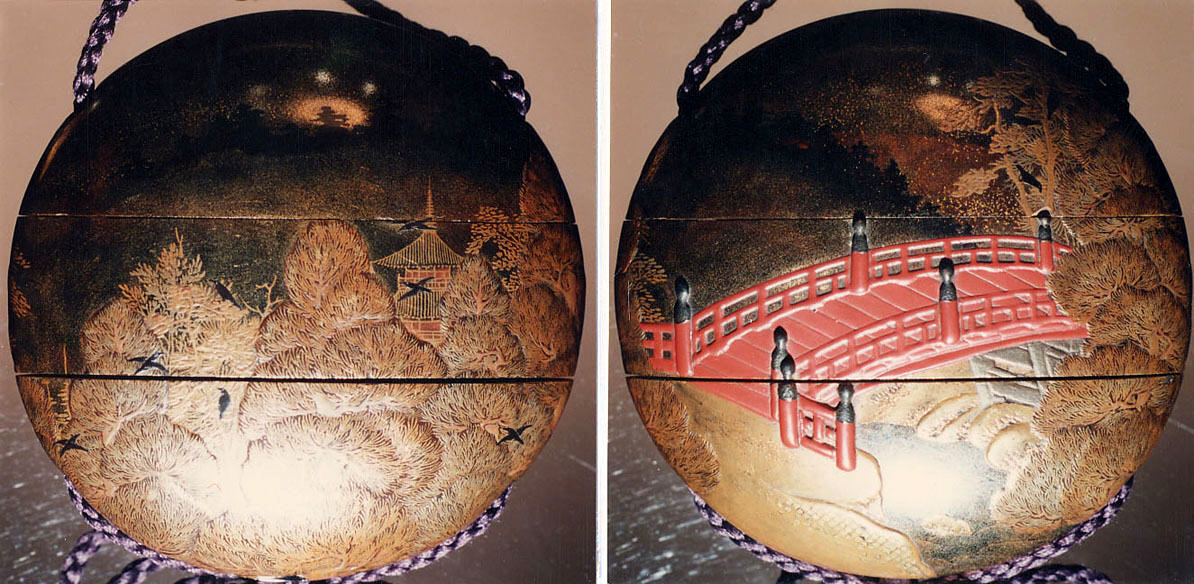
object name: inrō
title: Case (Inrō) with Design of Semi-Circular Bridge (obverse); Crows in Flight Beside Pagoda (reverse)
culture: japanese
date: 1701-1900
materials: gold, lacquer, metal, silver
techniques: fundame, hiramakie, maki-e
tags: birds,bridges,trees